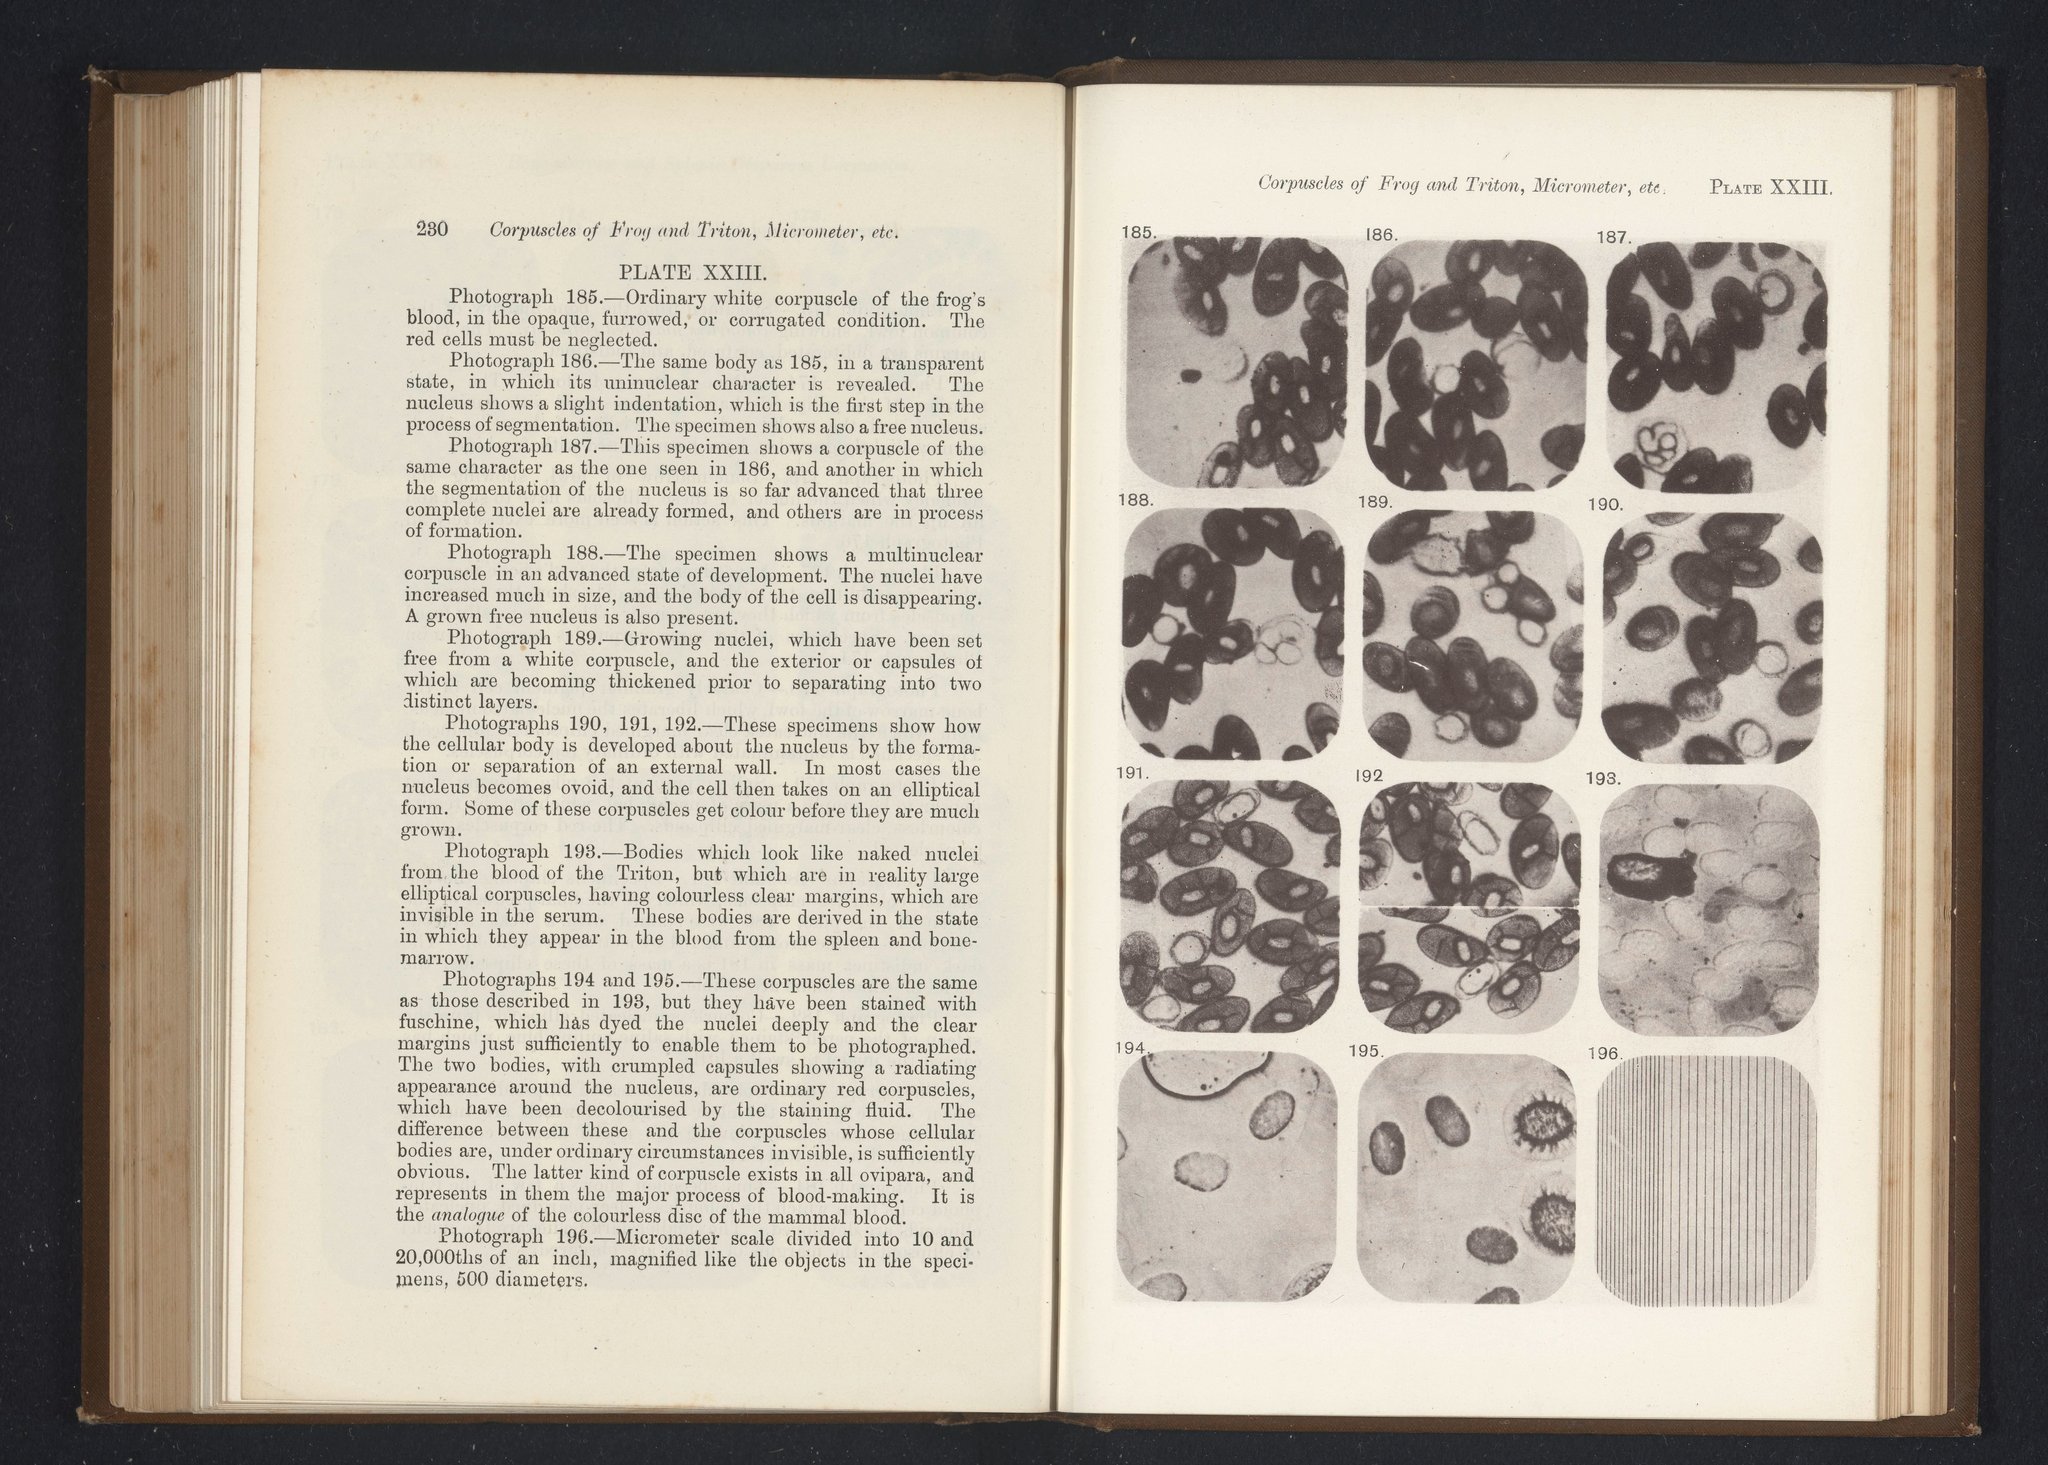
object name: page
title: Elf vergrotingen van bloedlichaampjes en een vergroting van een micrometer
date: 1872-1882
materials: paper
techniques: photograph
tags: blood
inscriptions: number: ‘Photo. 185. (...) Photo. 196.’, number: ‘Pl. XXIII.’